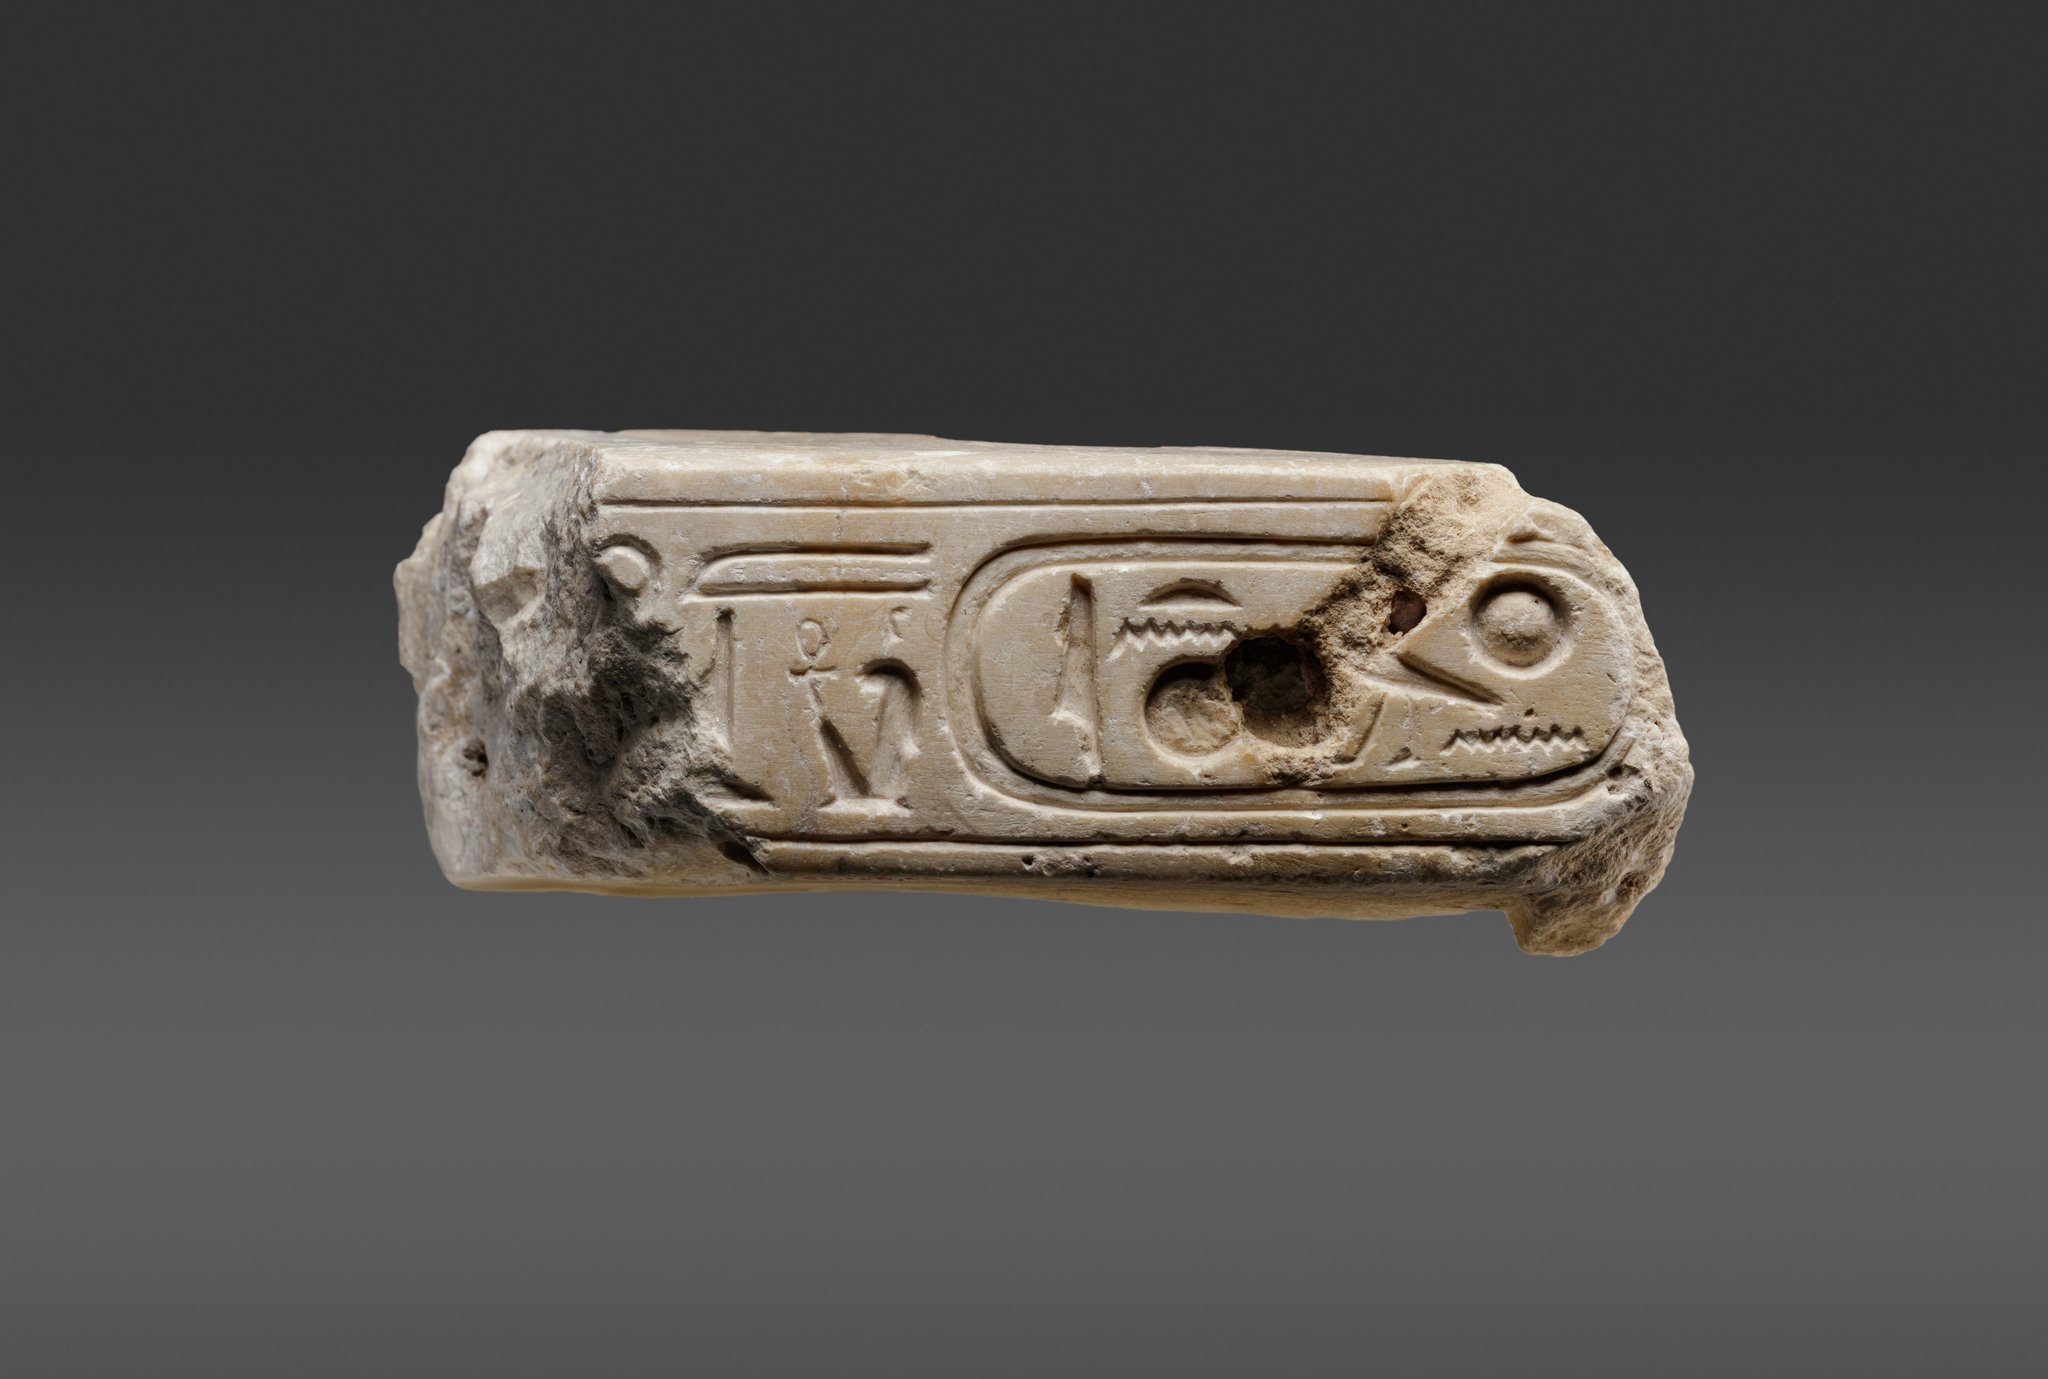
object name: offering table with hand, akhenaten name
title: Offering table with hand, Akhenaten names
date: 1353-1336 BCE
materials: limestone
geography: egypt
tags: hands,hieroglyphs